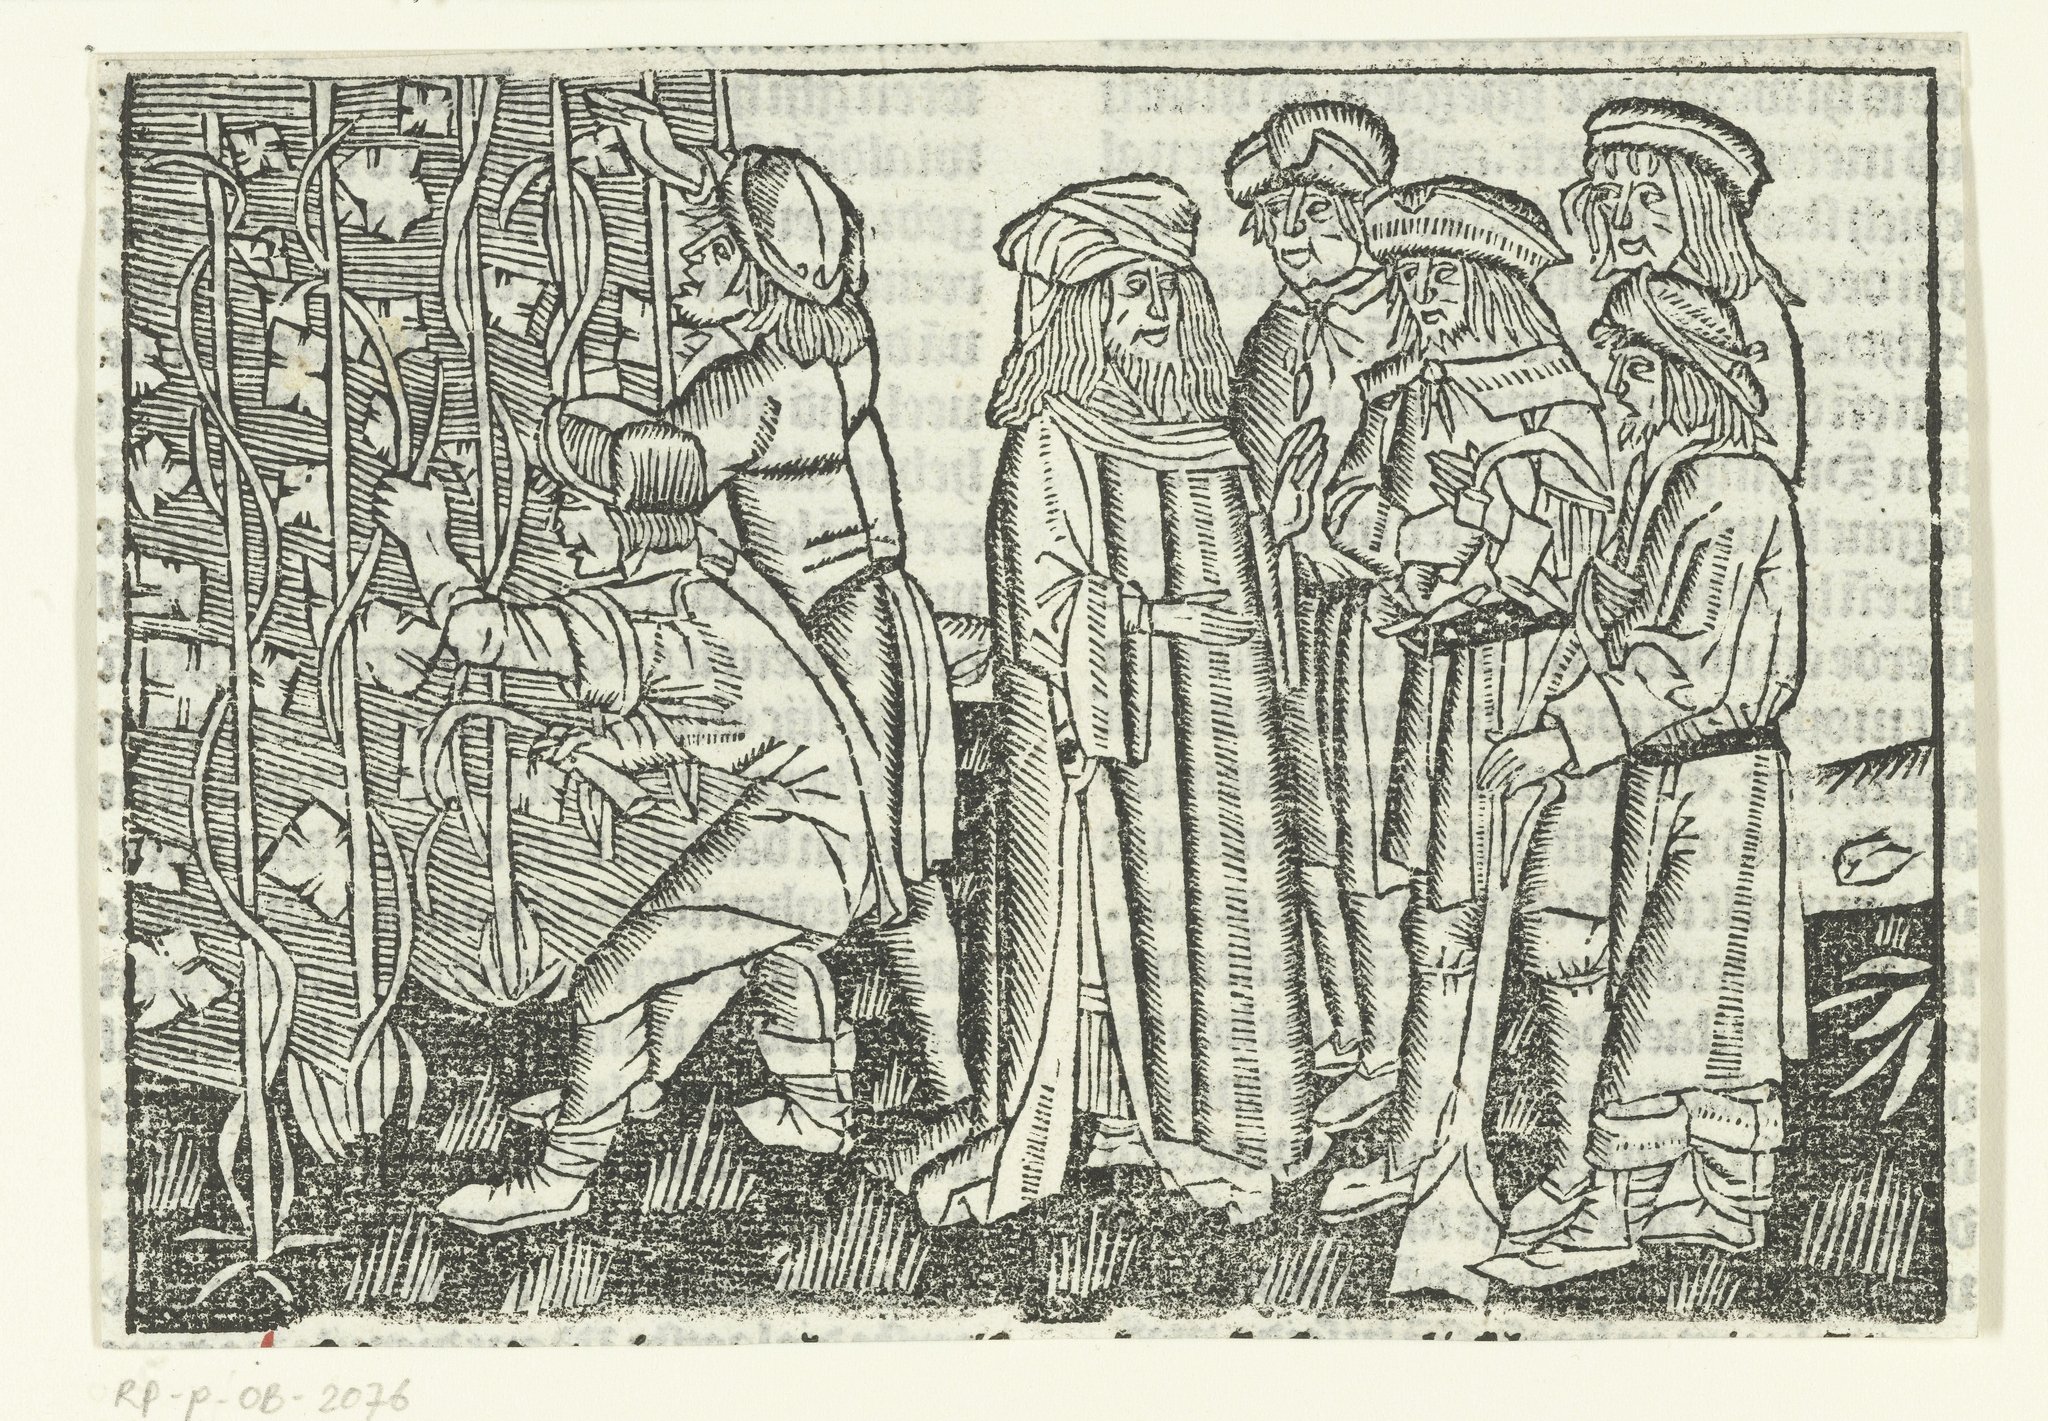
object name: print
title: Parabel van de werkers in de wijngaarde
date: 1480-1500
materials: paper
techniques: woodcut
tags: the labourers in the vineyard ~ parable of christ (matthew 20:1-16)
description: Eén blad van 113 uit Ludolphus de Saxonia, "Dit es dleué ons liefs heeren ihesu christi". Anonieme Nederlandse vertaling. Uitgegeven door Henrick Eckert van Homberch te Antwerpen in 1503. Botke, K. Deze 113 houtsneden, die meestal reeds in vroege Nederlandse boeken gebruikt zijn, worden toegeschreven aan de tweede Meester van Delft, de Meester van de Delbecq-Schreiber-passie en de Meester van de Virgo inter Virgines. In Conway (1884) en in "De gulden passer"(1951) zijn ook eerdere versies opgenomen. Botke, K.